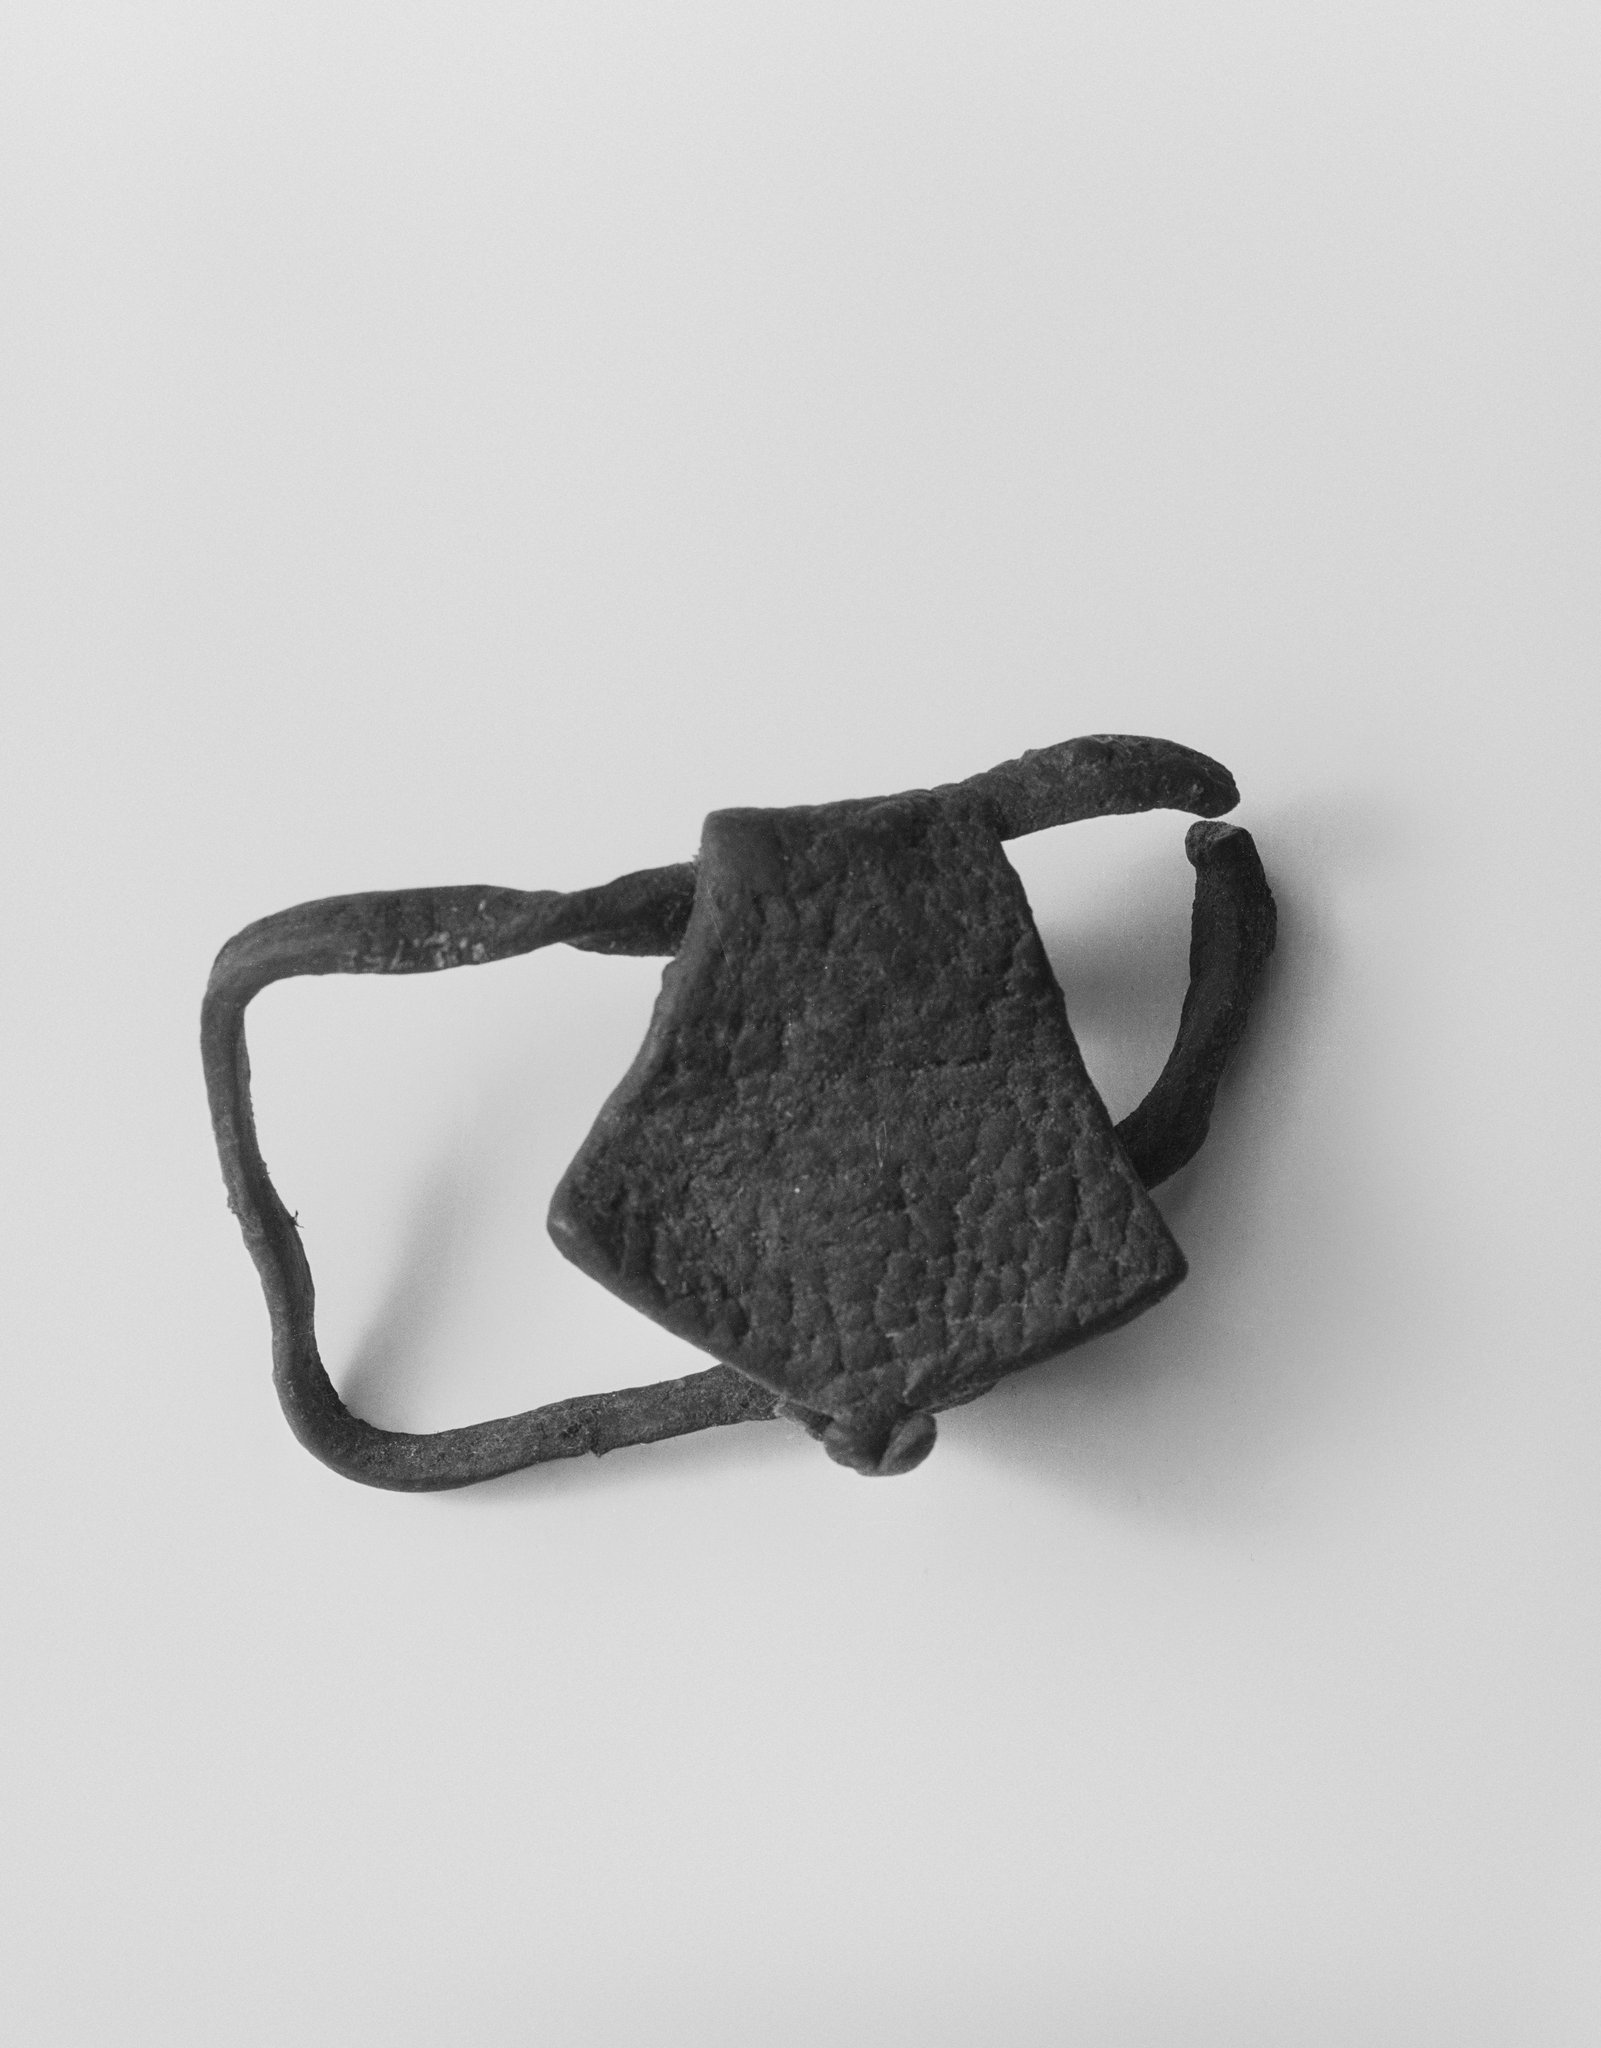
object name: archery, wrist guard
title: Archer's wrist guard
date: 1981-1550 BCE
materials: leather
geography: southern upper egypt